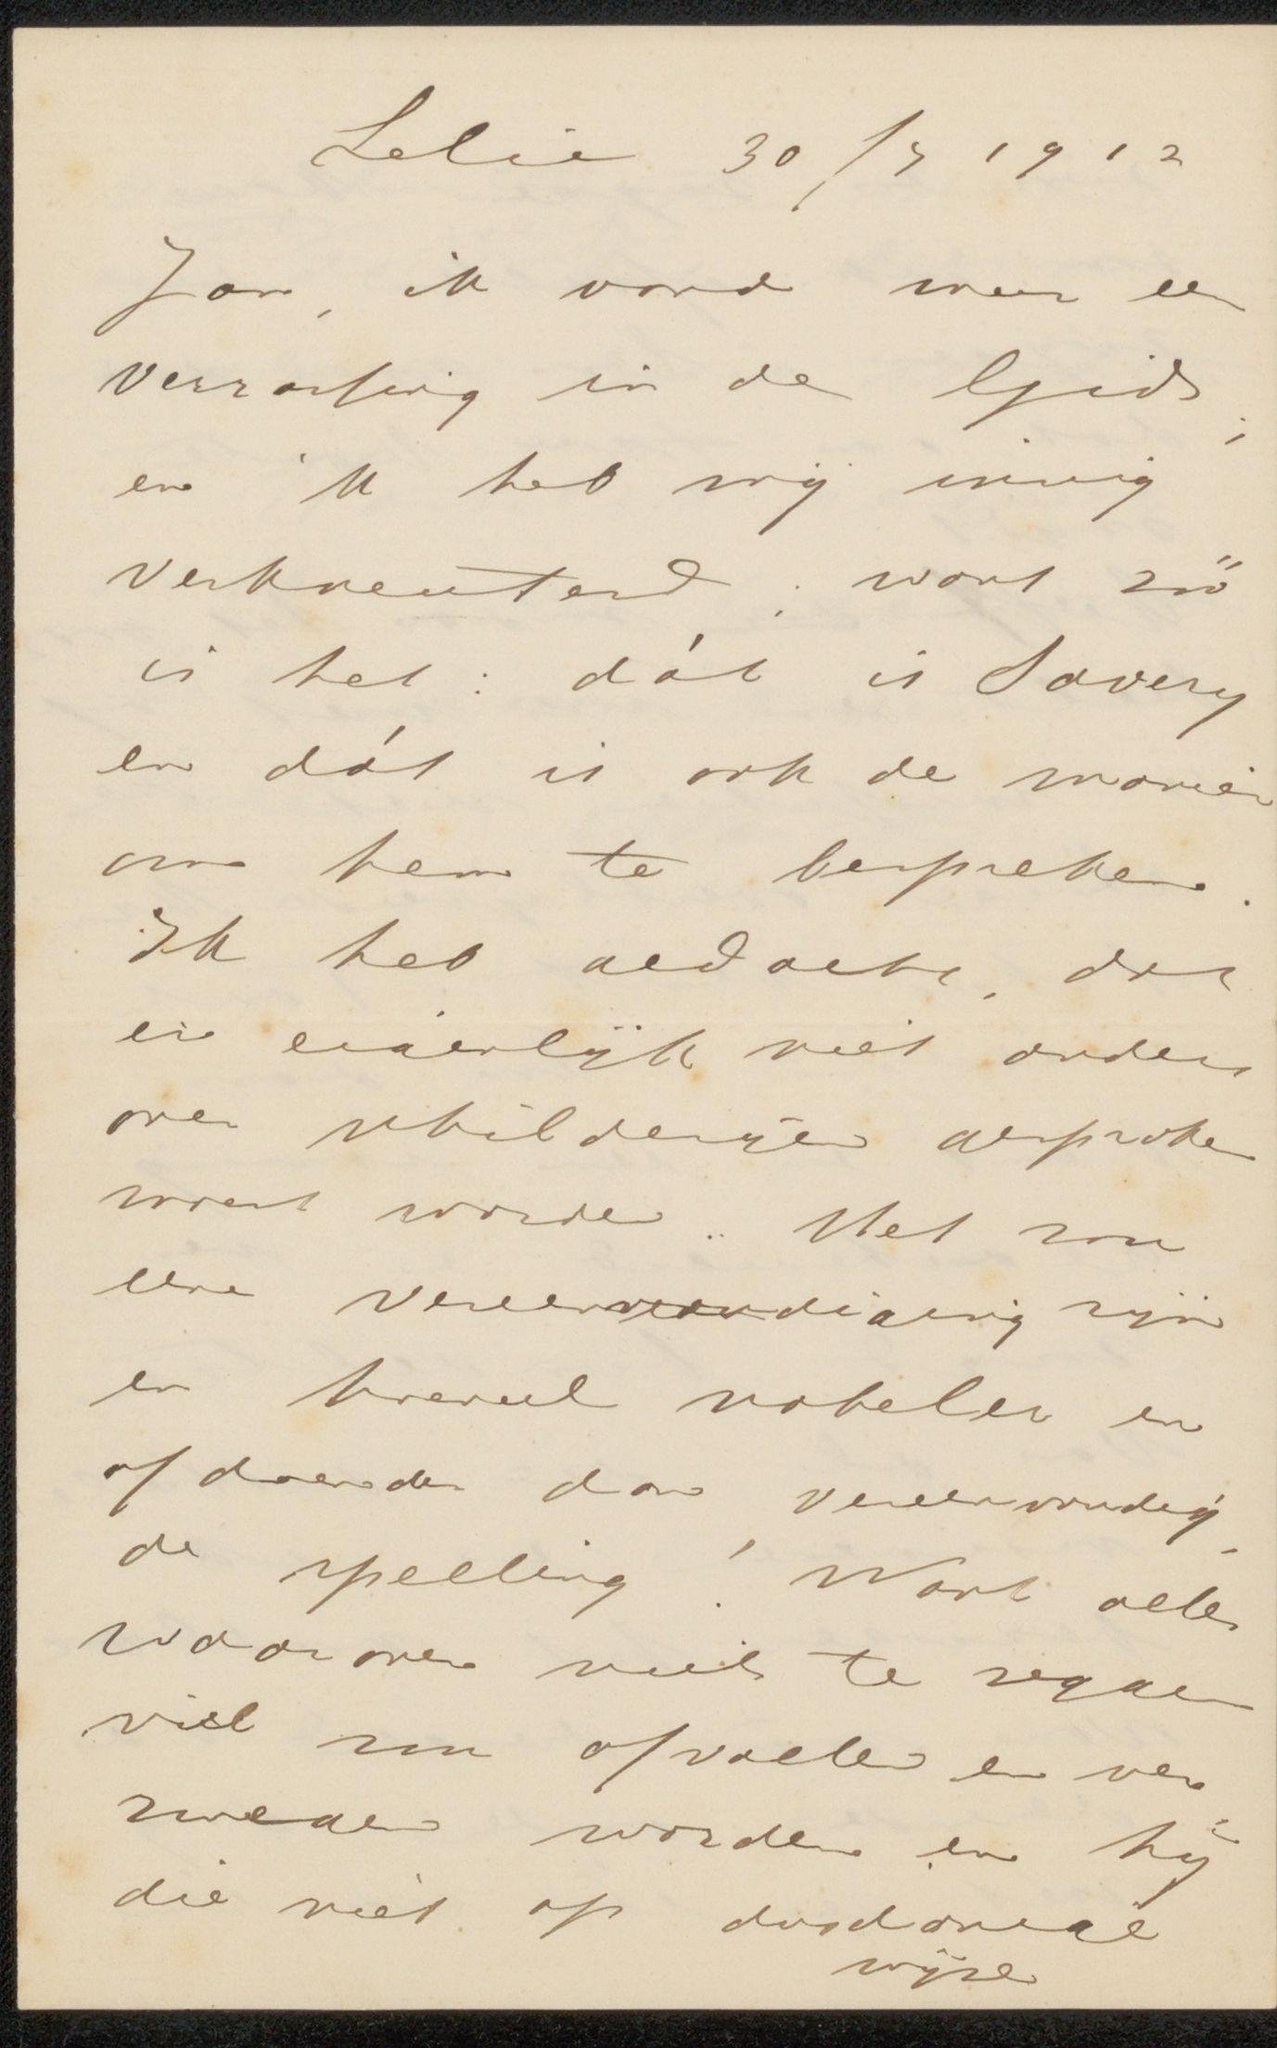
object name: letter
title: Brief aan Jan Veth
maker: martha van vloten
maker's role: vertaler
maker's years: 1856-1943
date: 1912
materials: ink, paper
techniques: pen, writing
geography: bussum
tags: utrecht, roelant savery, dordrecht, amsterdam, painter, draughtsman, designer, jan veth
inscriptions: collector's mark: ‘RPK’, watermark